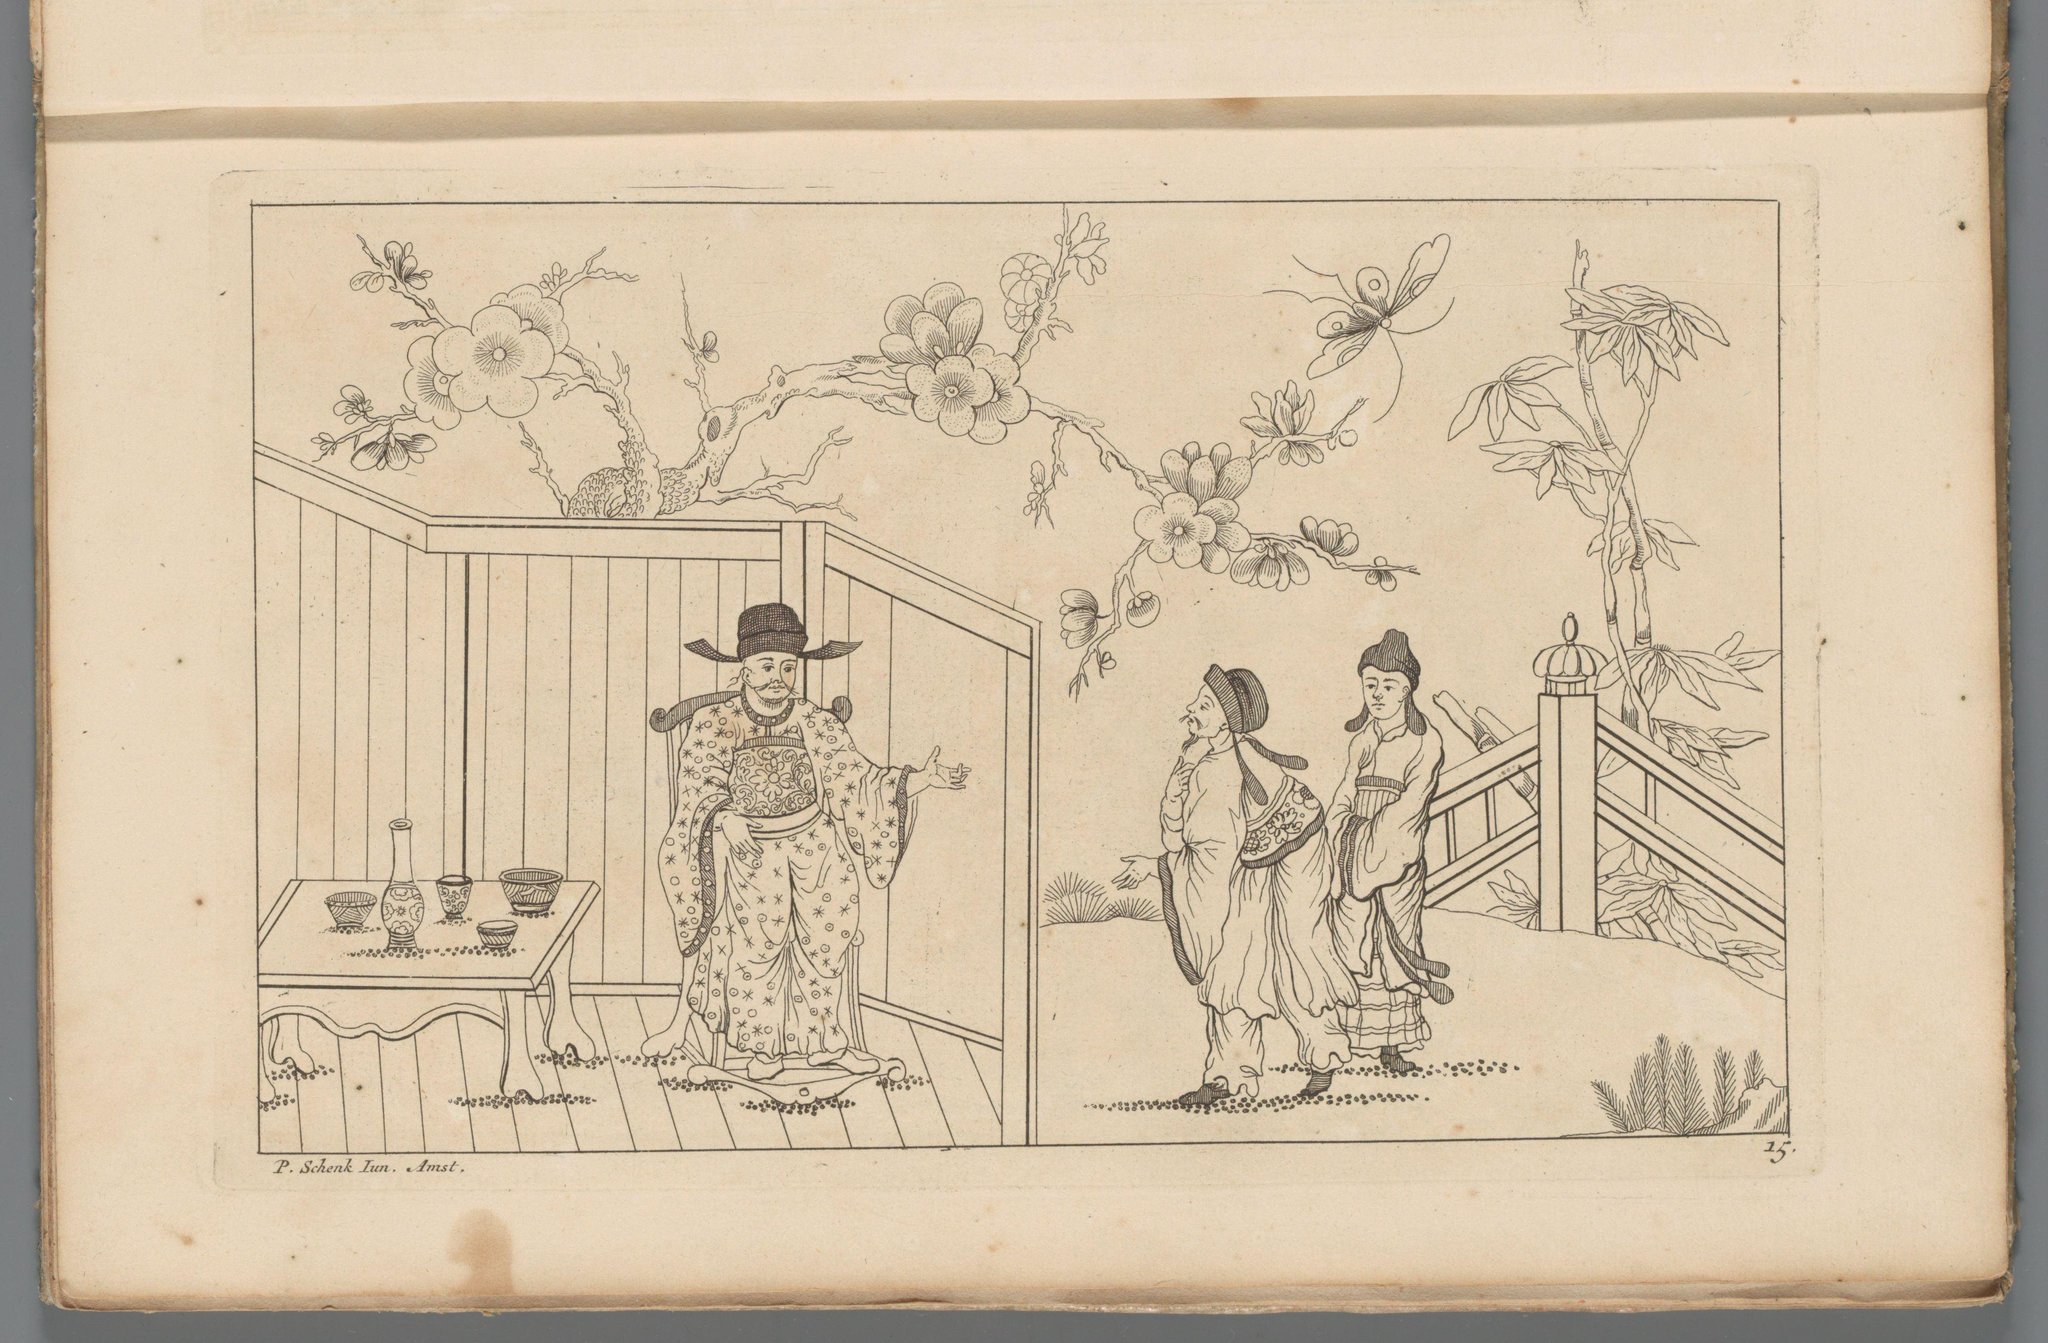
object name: print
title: Nieuwe geinventeerde Sineesen met groote moeyte geteekent en in 't Ligt gegeven, door P. Schenk Jun (...), tweede deel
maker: pieter schenk (ii)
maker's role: draughtsman, print maker, publisher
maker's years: 1693-1775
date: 1727-1775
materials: paper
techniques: etching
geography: amsterdam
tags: chinese (+ costume), trees (+ flowers, blossom, blossoming)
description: Rijk geklede Chinese man in een stoel bij een gedekte tafel. Rechts twee figuren. Op de achtergrond bloesemtakken. Prent maakt deel uit van een album.